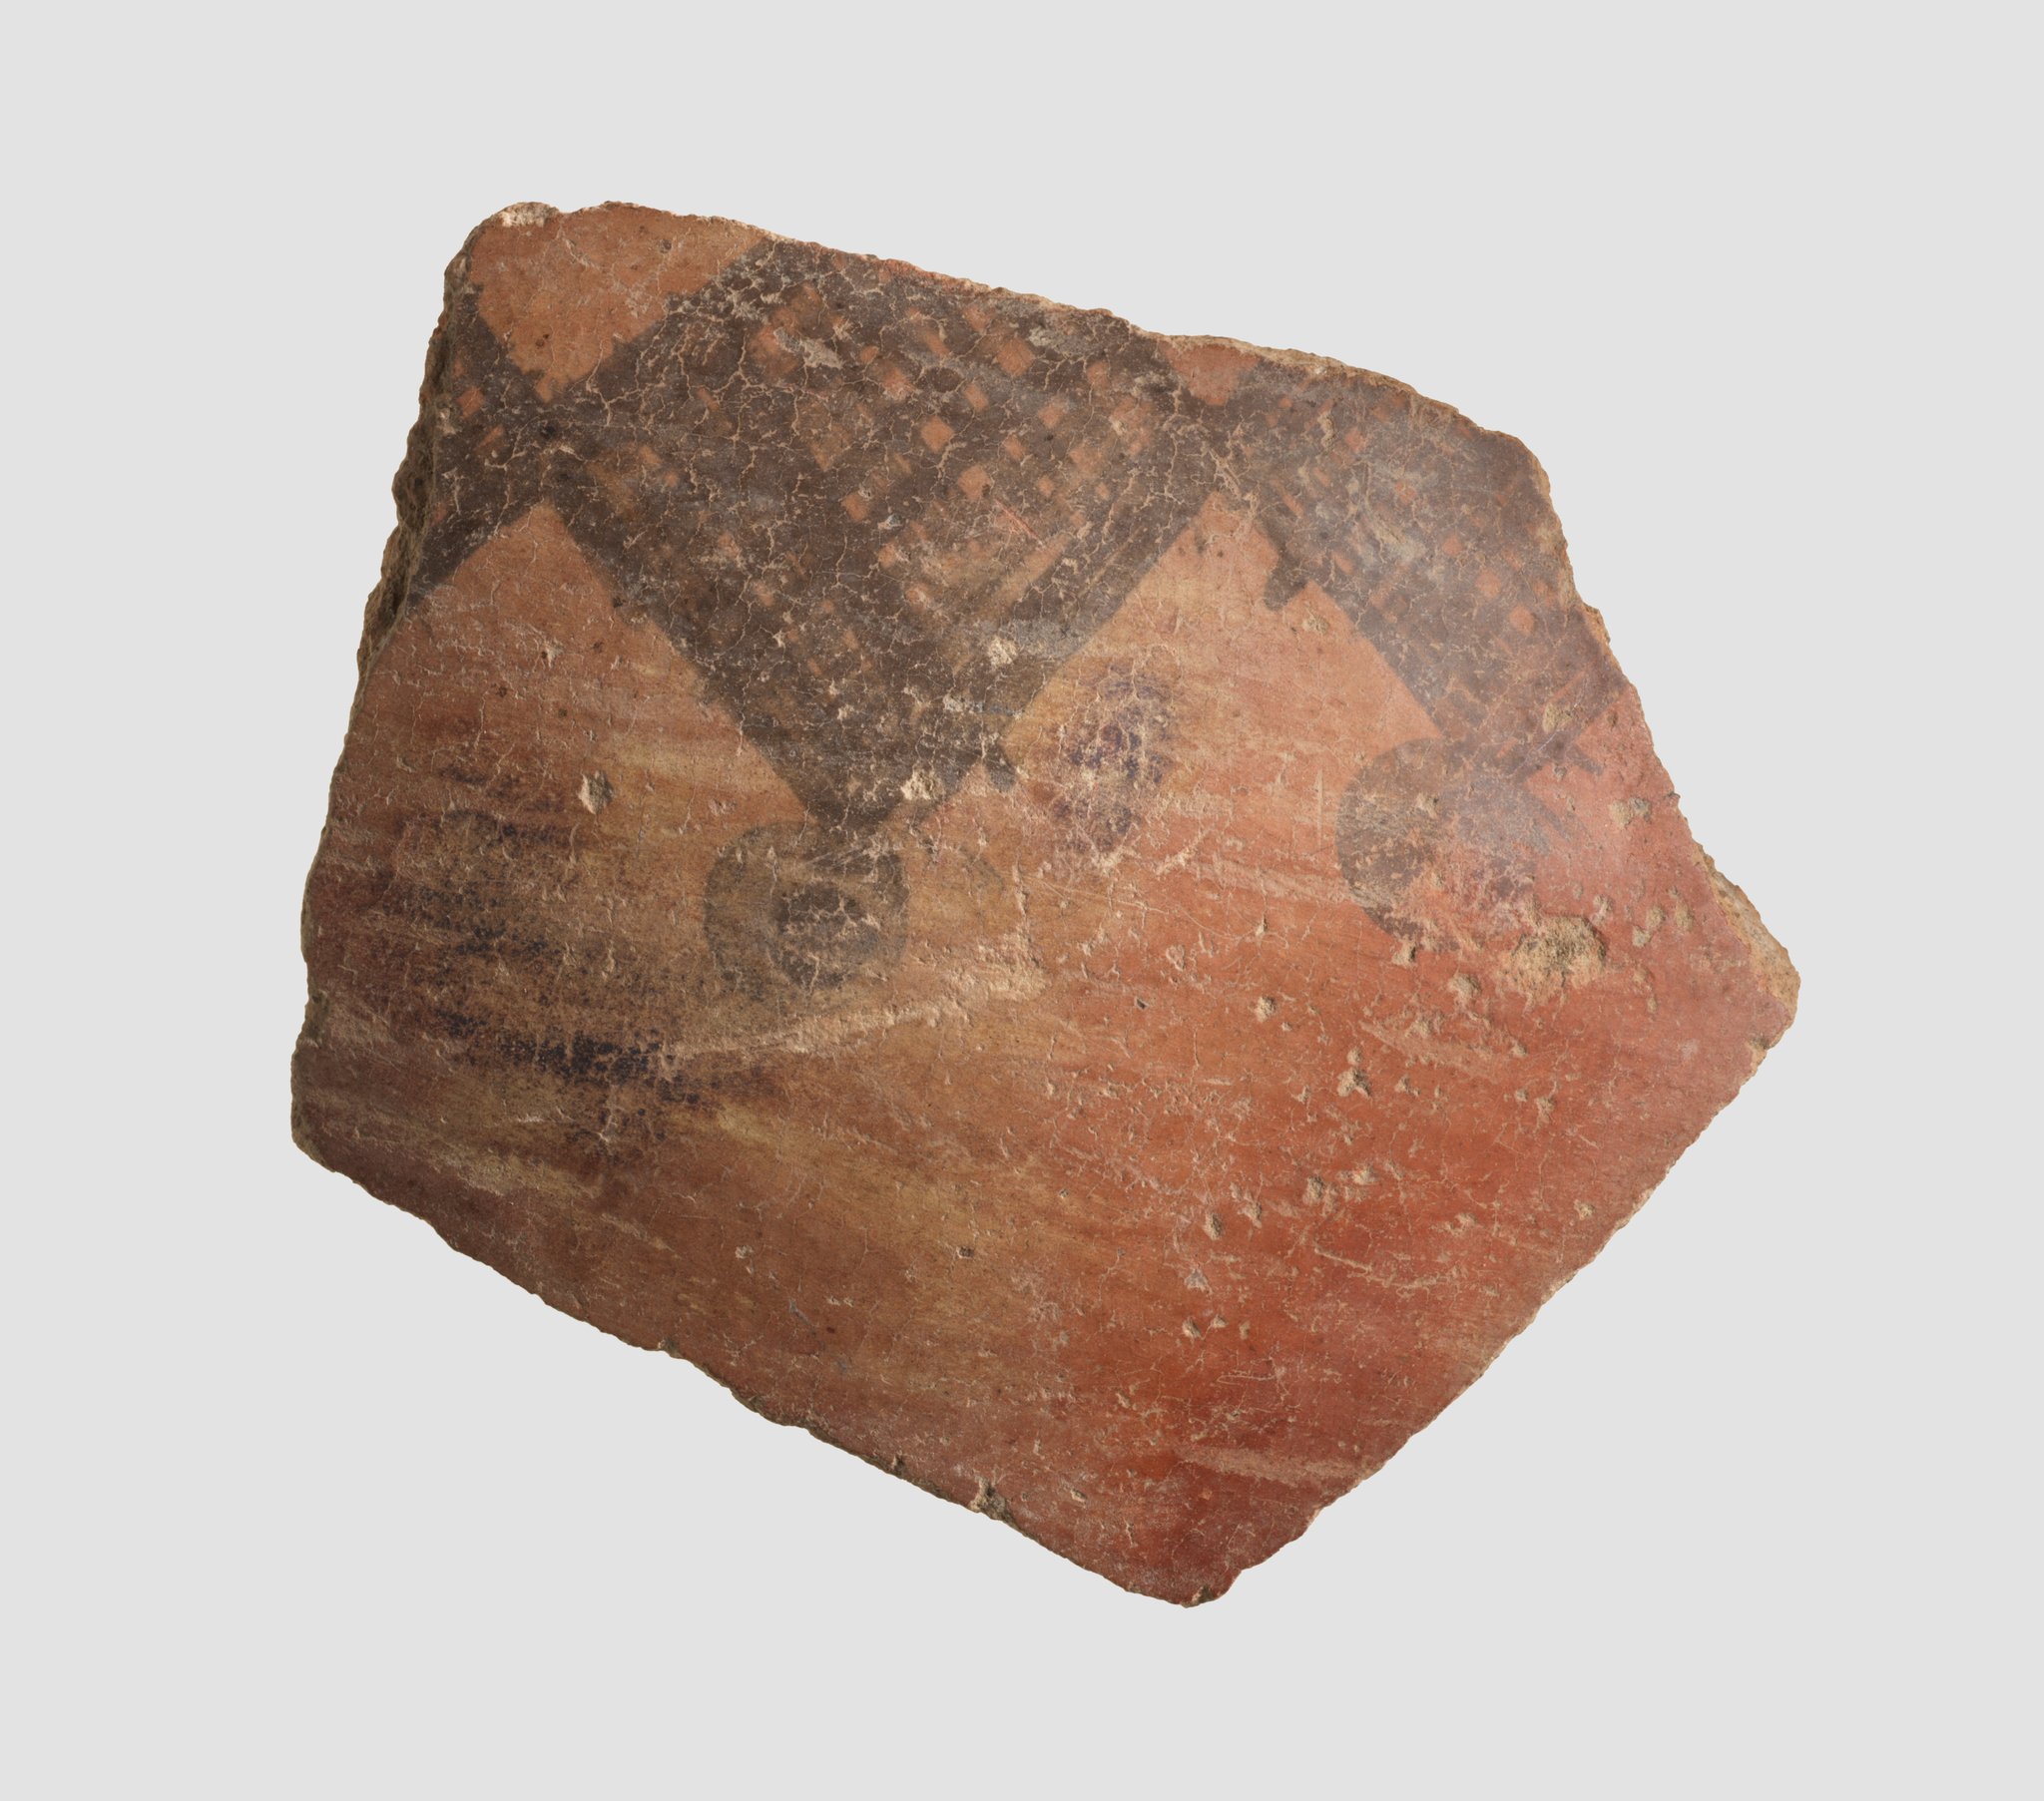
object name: sherd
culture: iranian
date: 1500-1000 BCE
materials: ceramic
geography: iran